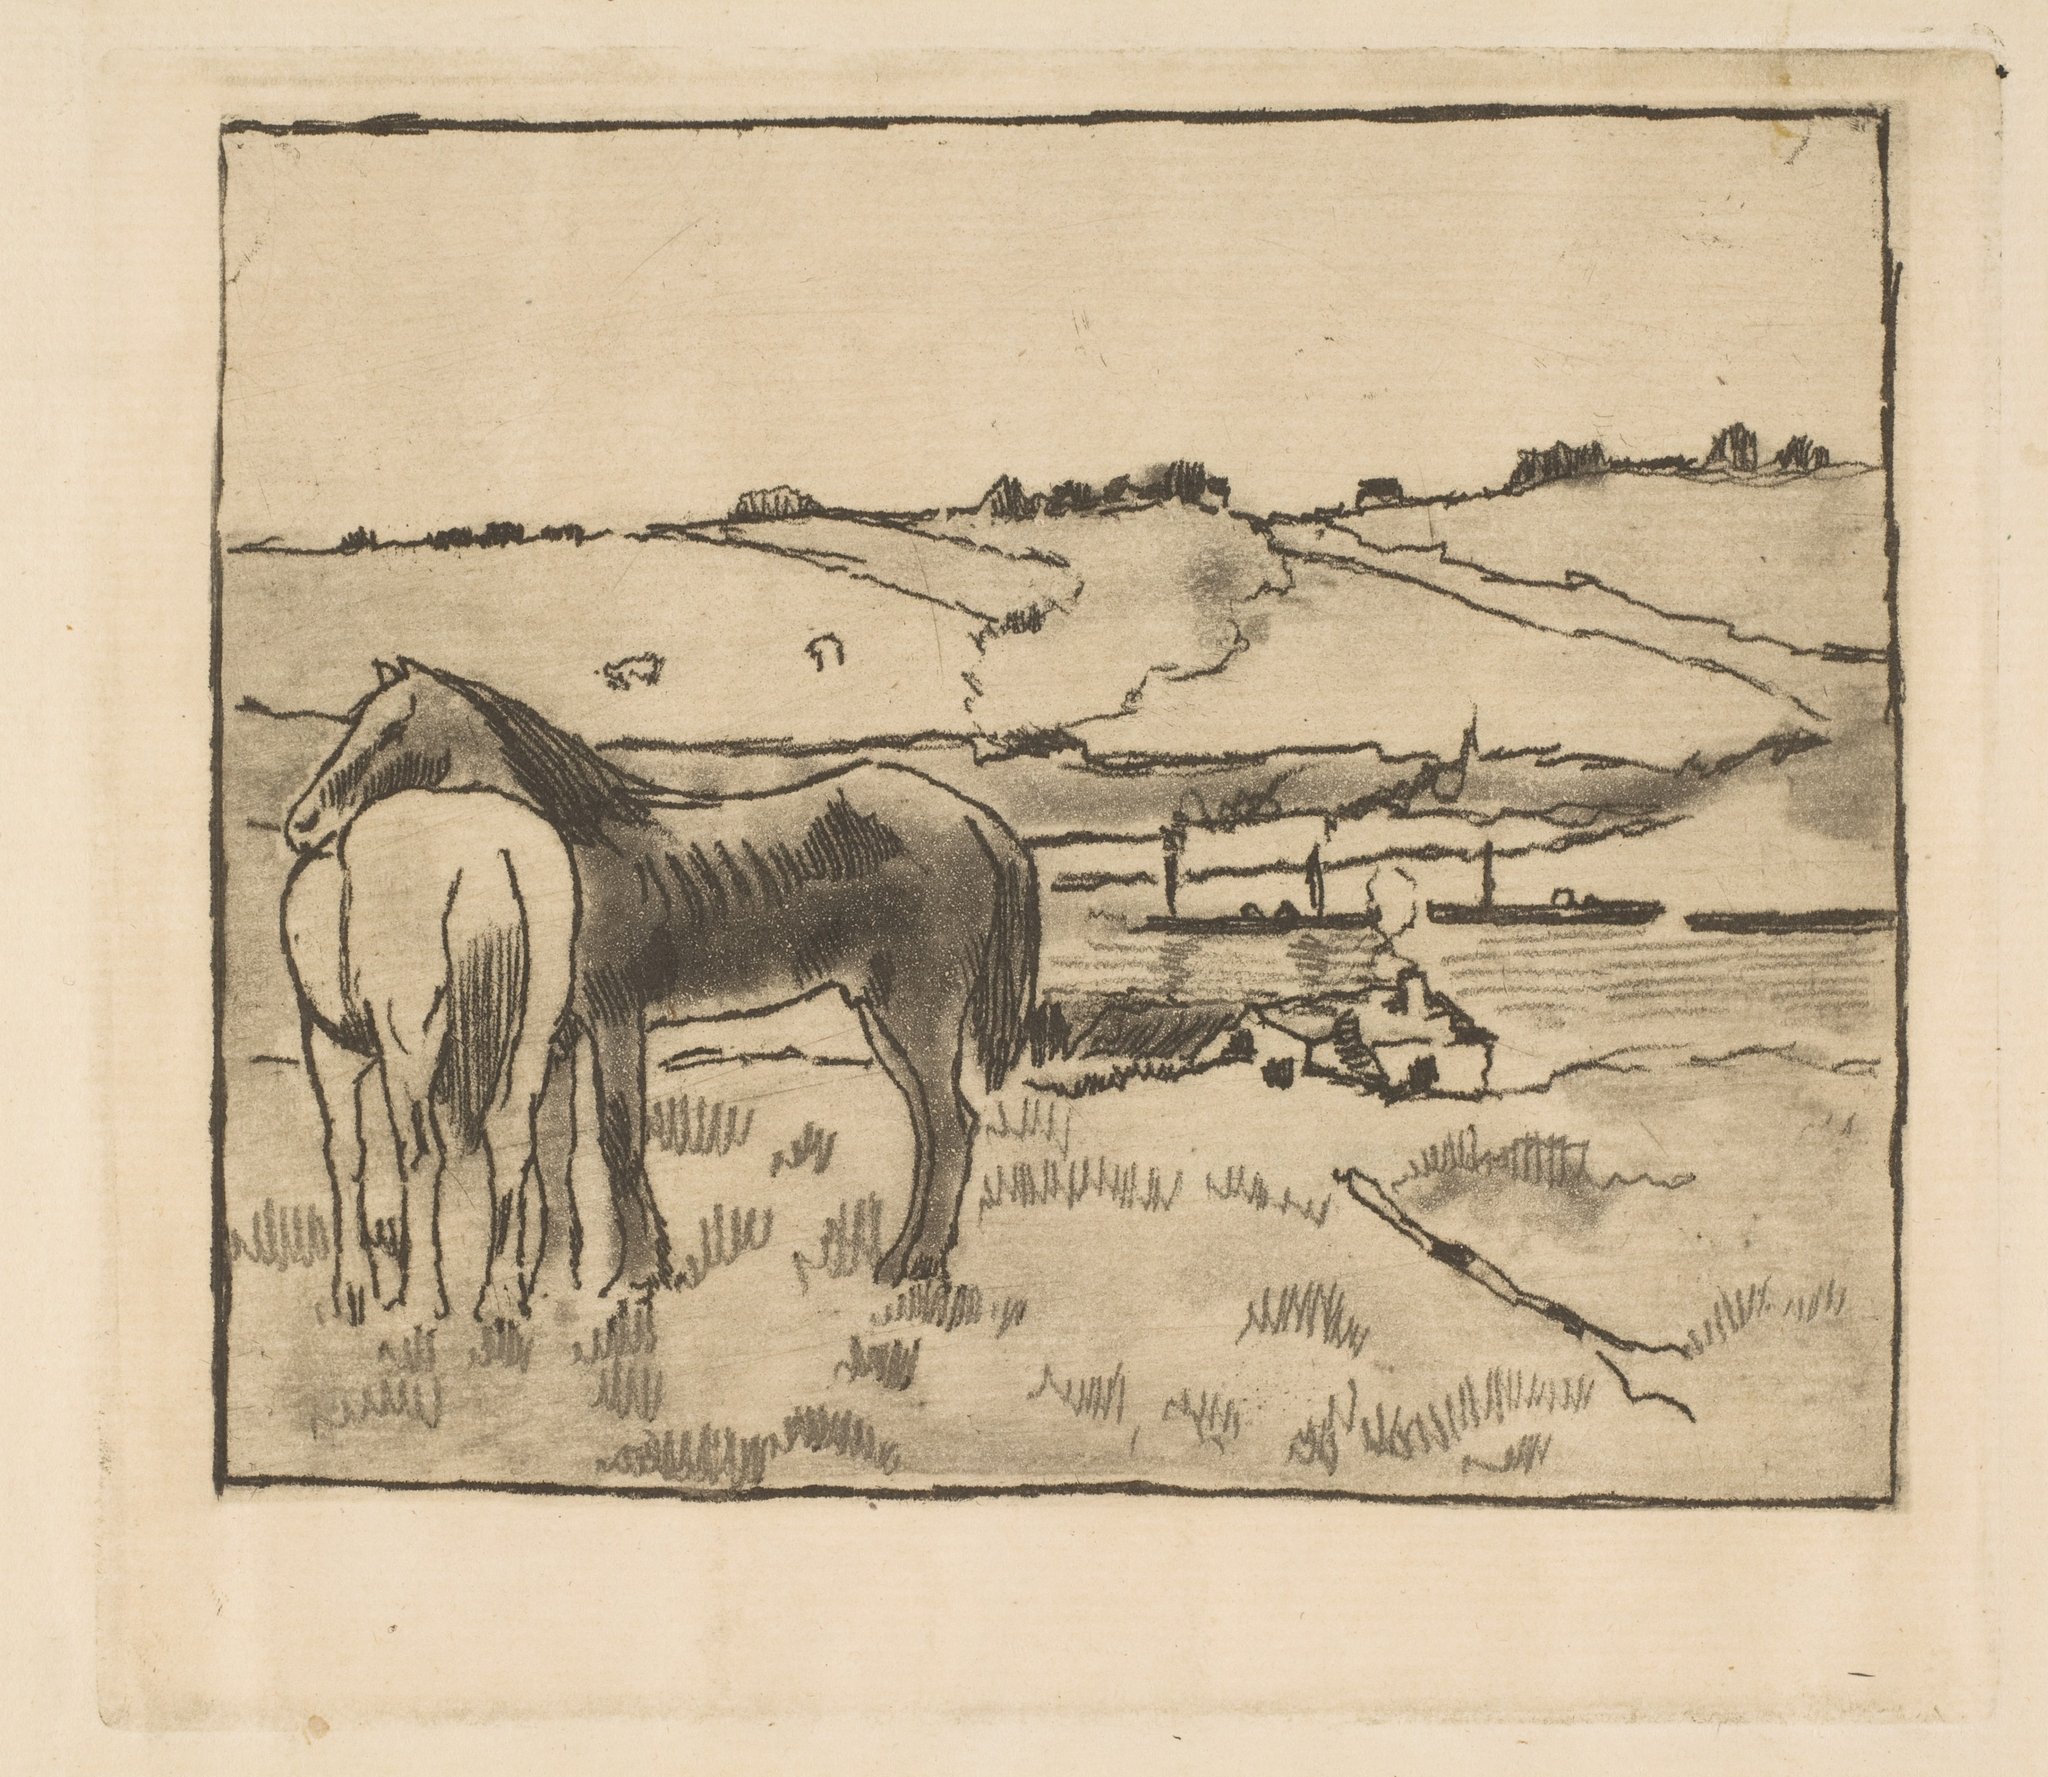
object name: print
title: Horses in the Meadow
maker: edgar degas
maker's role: artist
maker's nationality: french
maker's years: 1834-1917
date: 1891-1892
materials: paper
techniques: aquatint, drypoint, etching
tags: horses